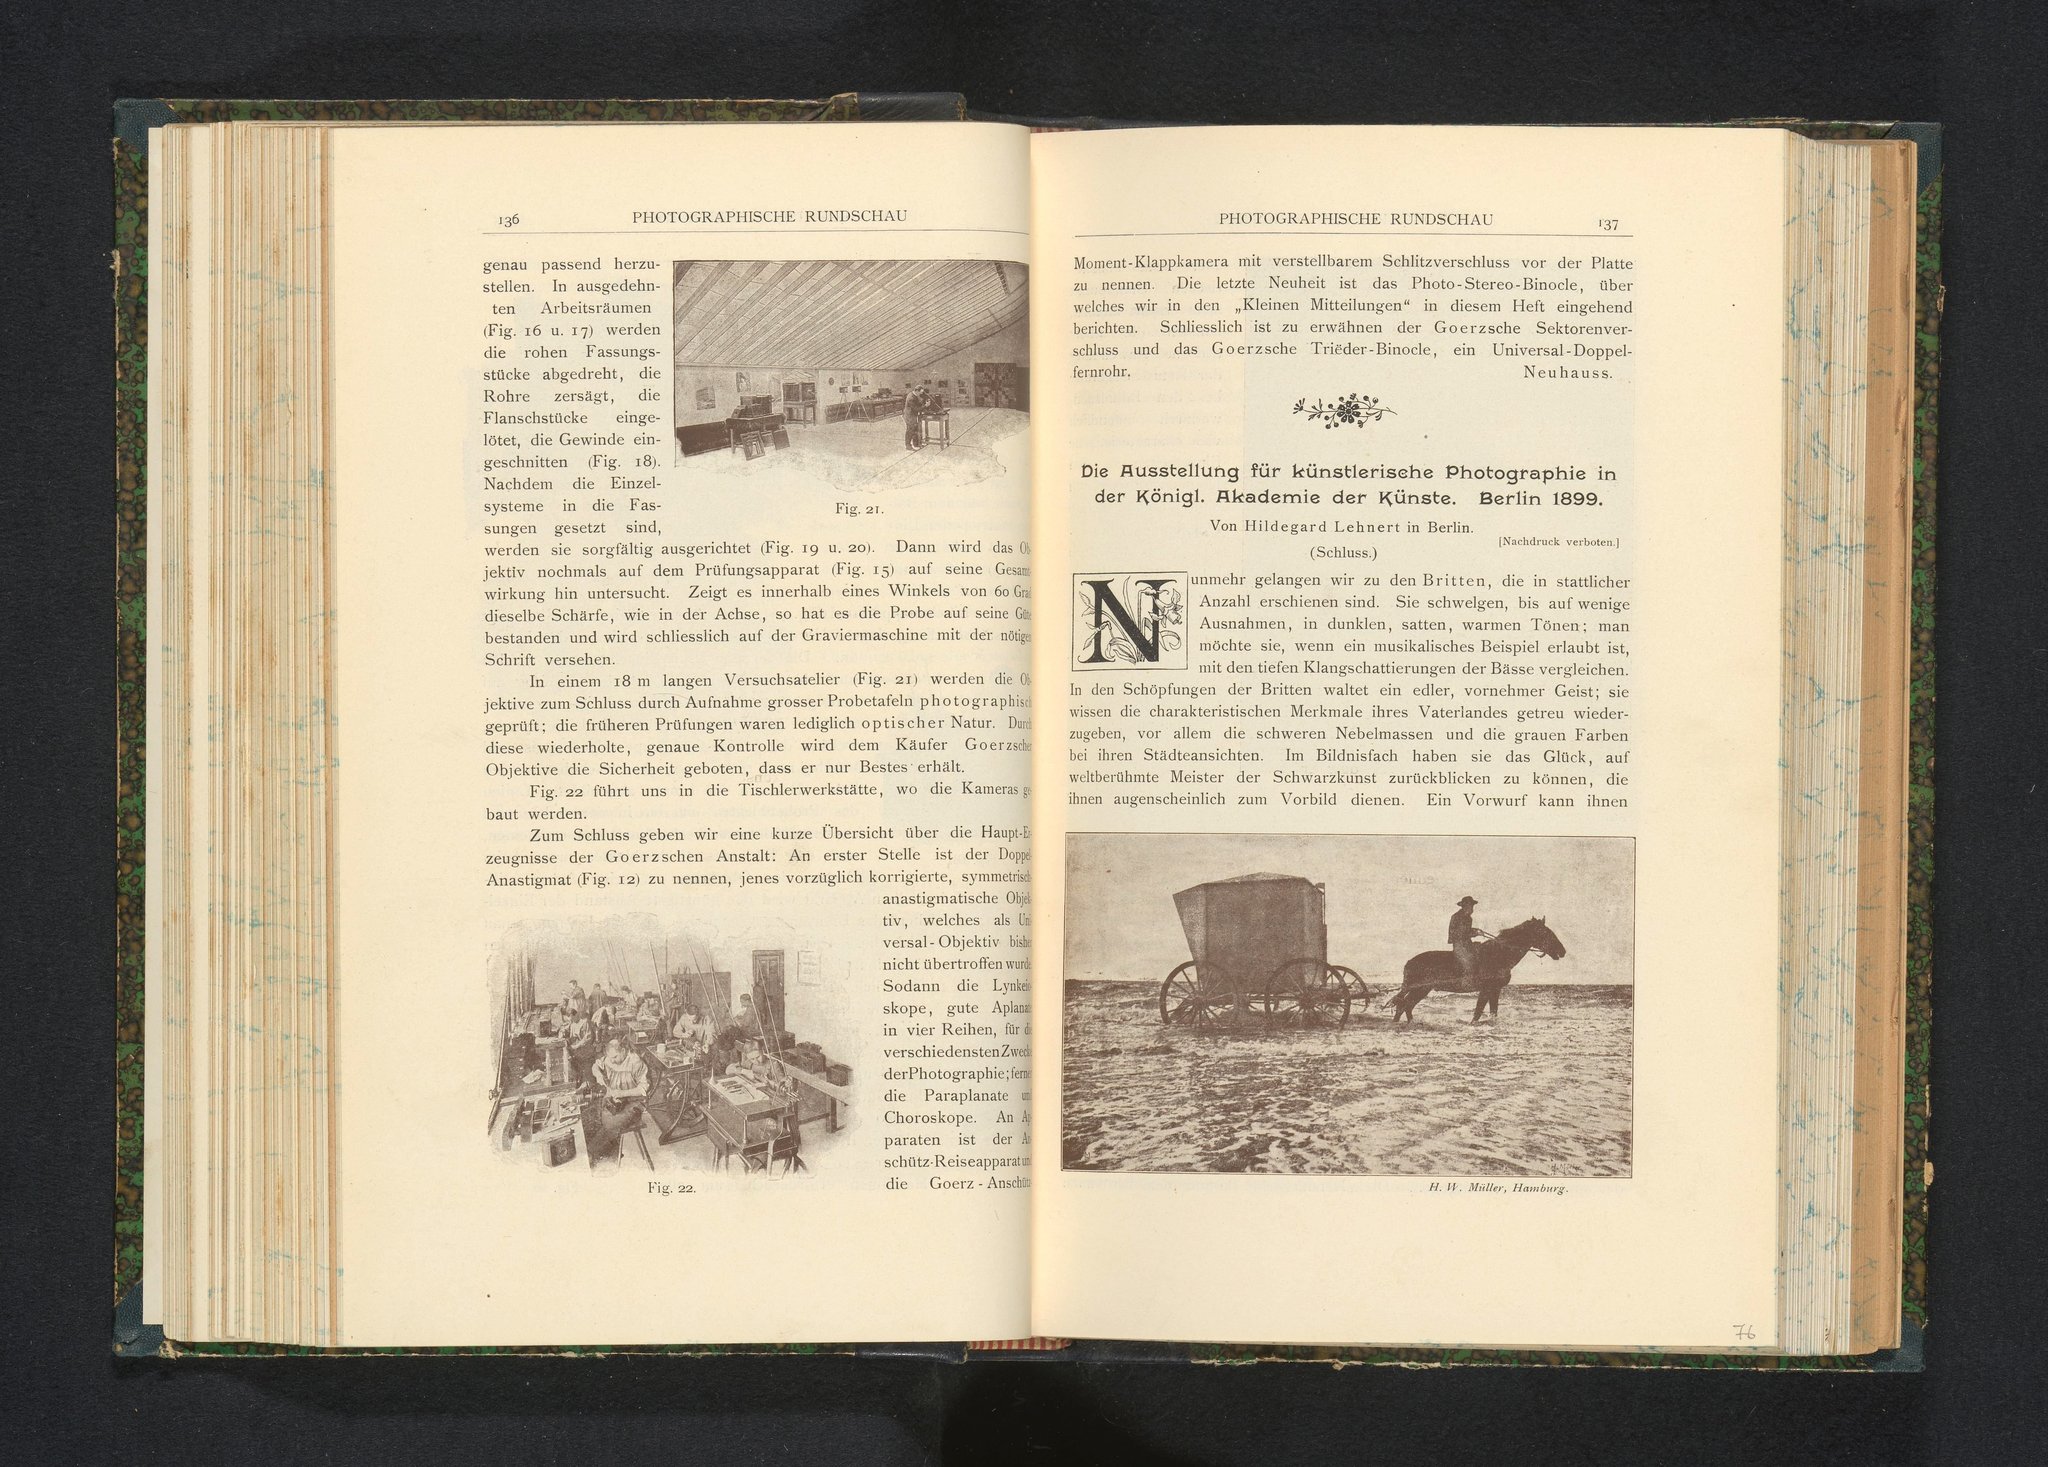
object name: photomechanical print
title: Paard met ruiter voor een wagen gespannen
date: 1894-1899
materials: paper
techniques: autotype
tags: riding a horse, ass, or mule; rider, horseman, four-wheeled, animal-drawn vehicle, e.g.: cab, carriage, coach, horse